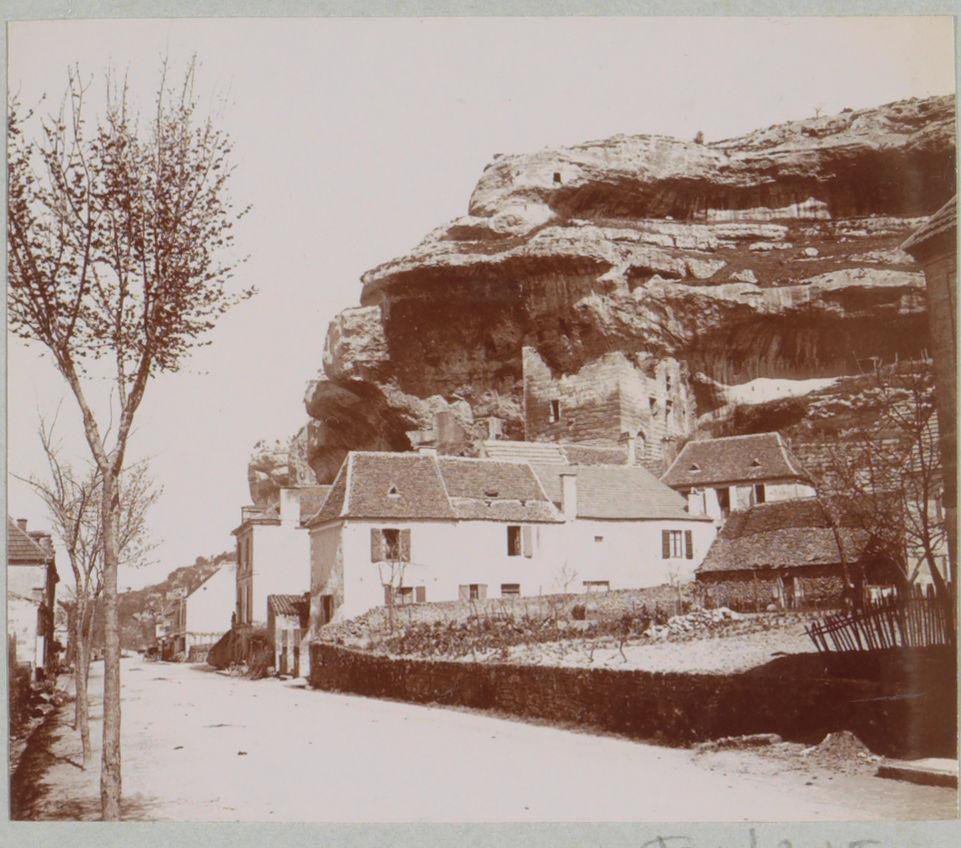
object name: photograph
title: Gezicht op huizen en rotswand van Les Eyzies-de-Tayac-Sireuil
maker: delizy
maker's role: manufacturer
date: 1904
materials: paper, photographic support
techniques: gelatin silver print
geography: biron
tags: prospect of village, silhouette of village, rock-formations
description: Onderdeel van Fotoalbum van een Franse amateurfotograaf met opnames van uitstapjes in Frankrijk, Spanje, België, Luxemburg en Nederland, de eerste automobielen en autoraces.